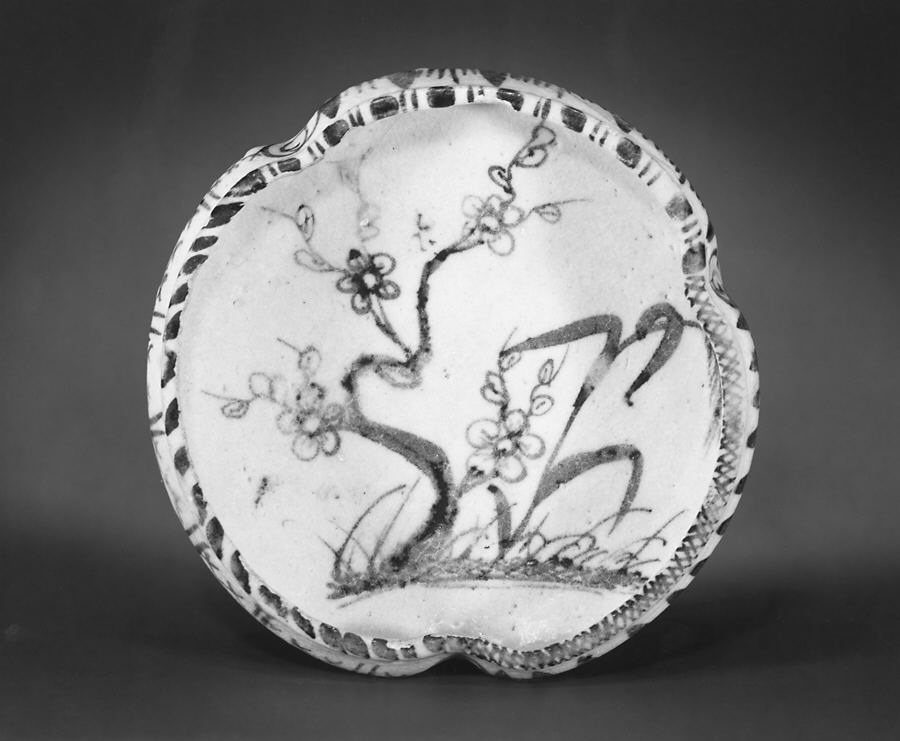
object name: dish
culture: japanese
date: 1601-1700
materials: pottery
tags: flowers